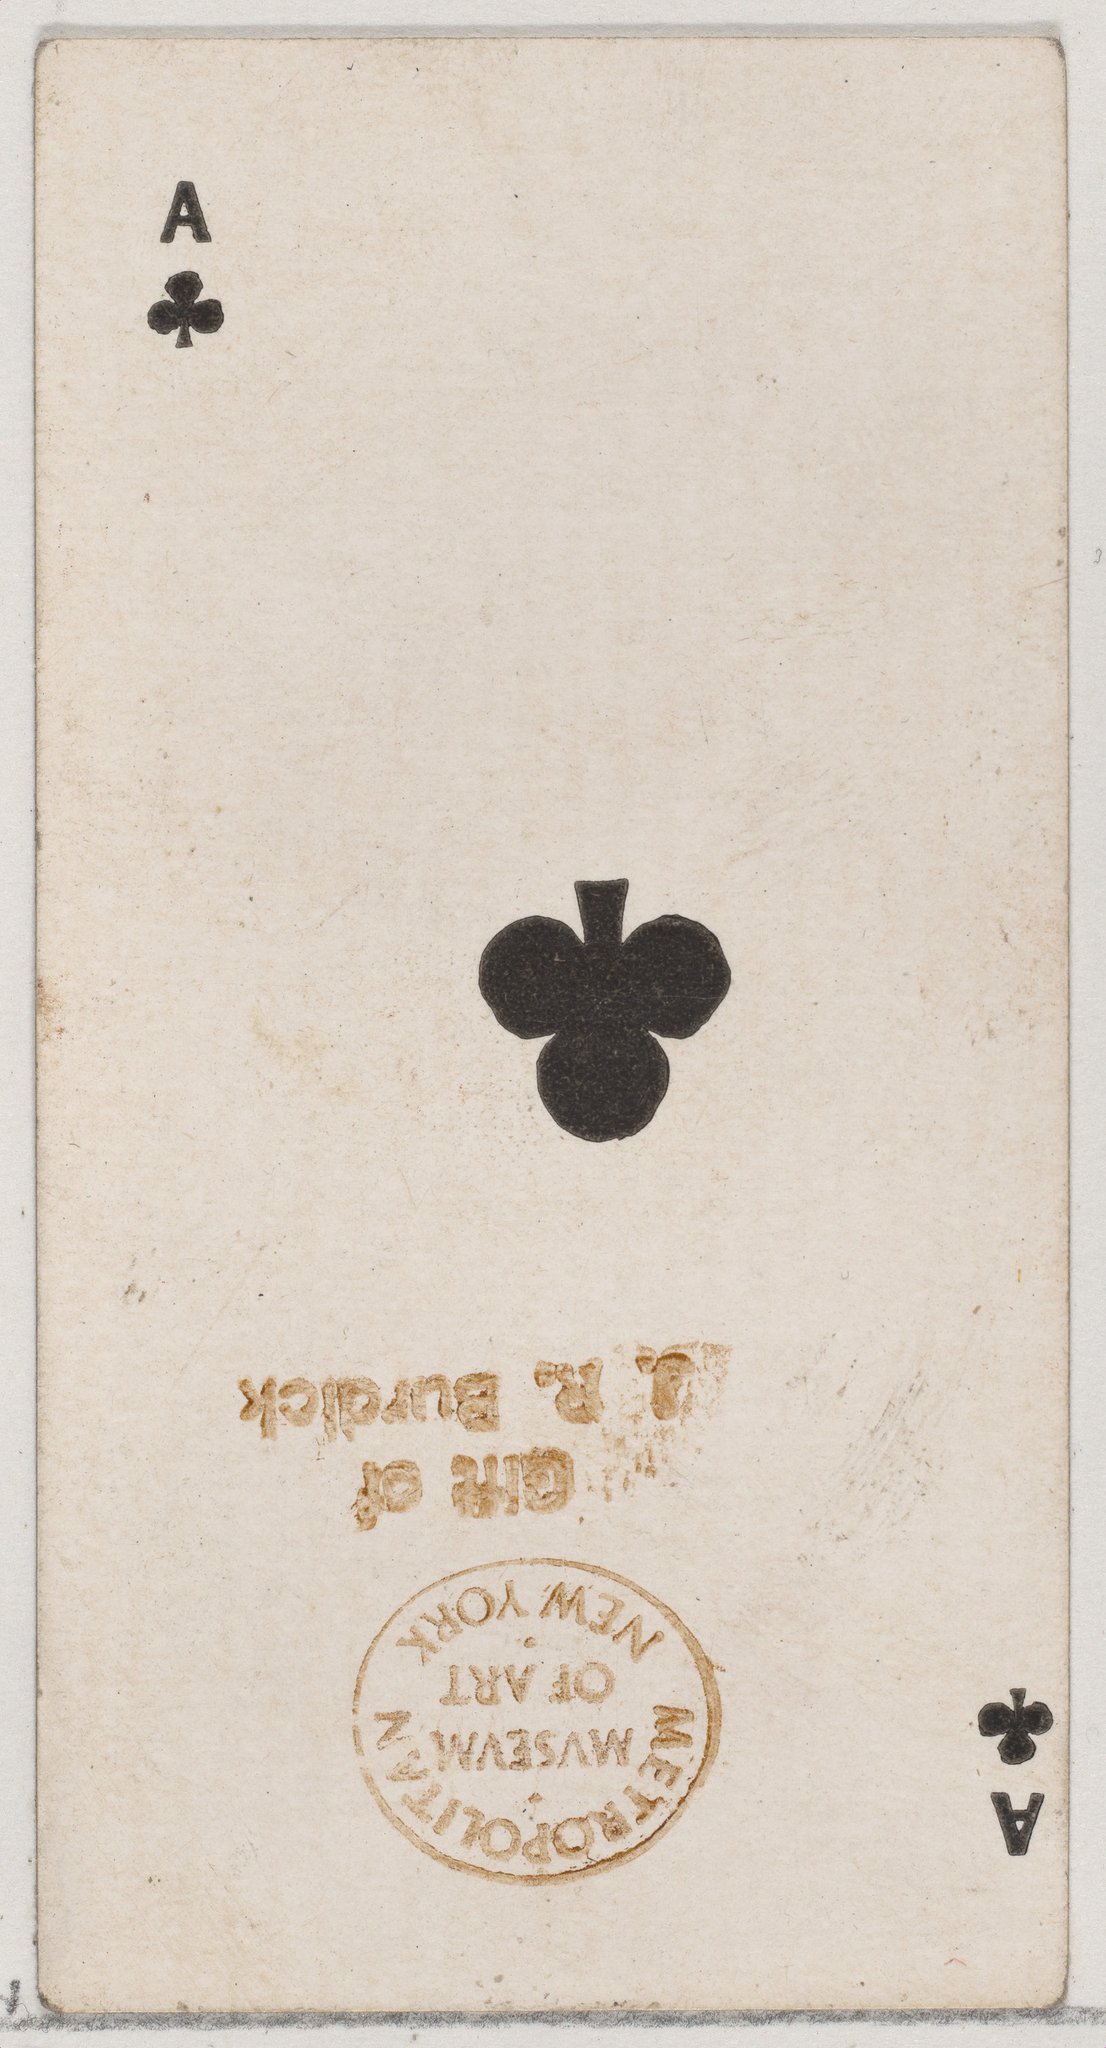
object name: print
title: Ace of Clubs (black), from the Playing Cards series (N84) for Duke brand cigarettes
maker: w. duke, sons & co.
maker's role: publisher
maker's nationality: american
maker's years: 1870-1920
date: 1888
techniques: color lithograph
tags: playing cards